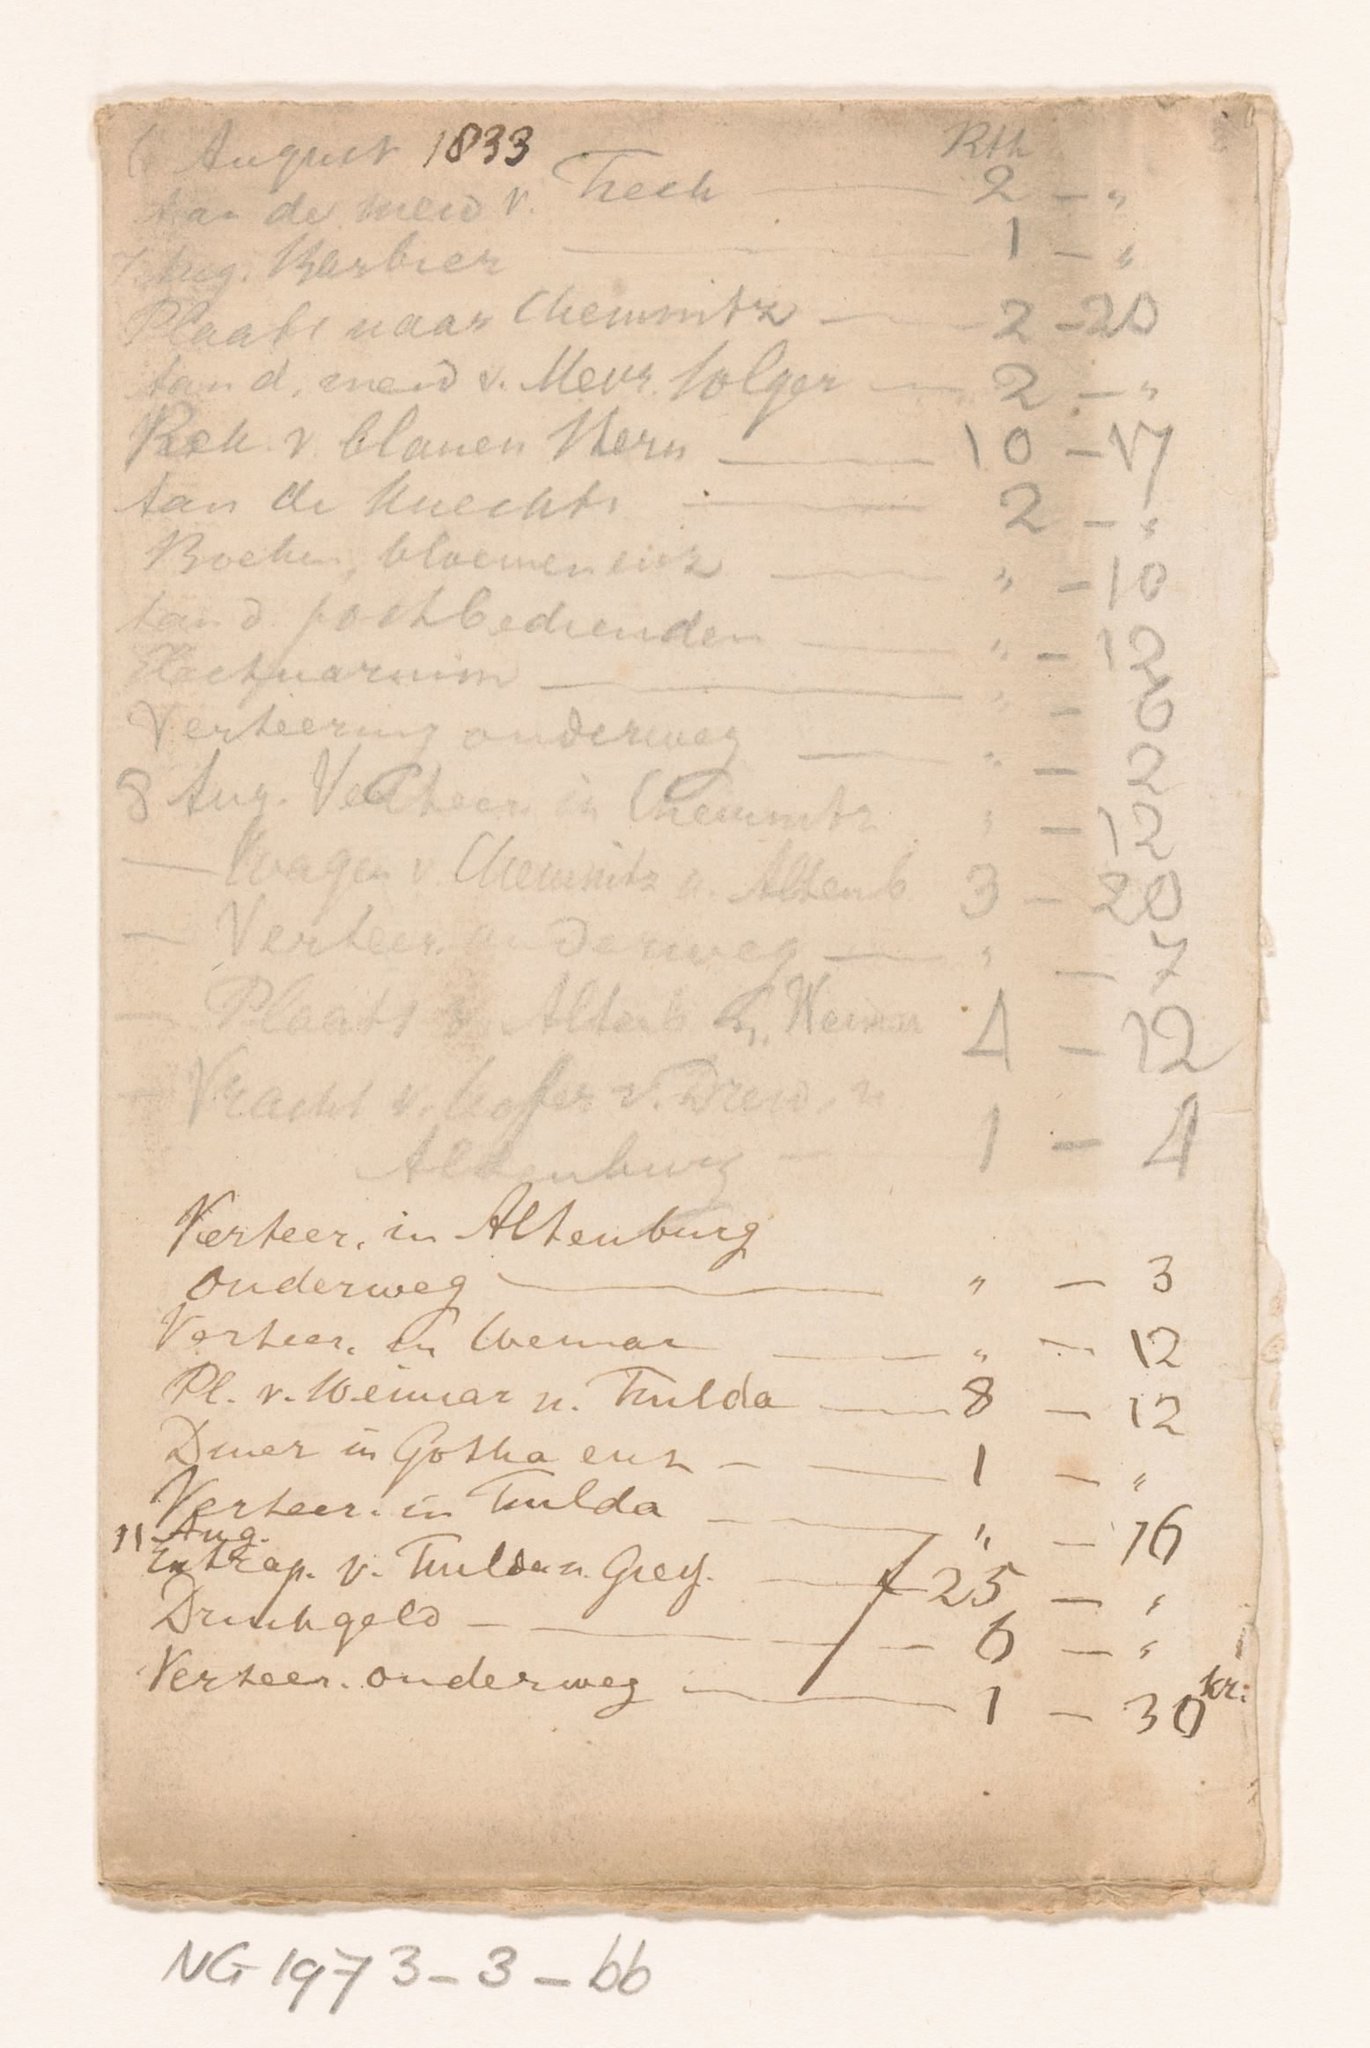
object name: travel document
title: Reisdocument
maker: Anonymous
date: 1808-1833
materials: paper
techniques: printing, writing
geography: netherlands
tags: the hague, johan rudolf thorbecke, germany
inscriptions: date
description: Handgeschreven, gevouwen vel met persoonlijke reisuitgaven. Gedateerd: aug. 1833.